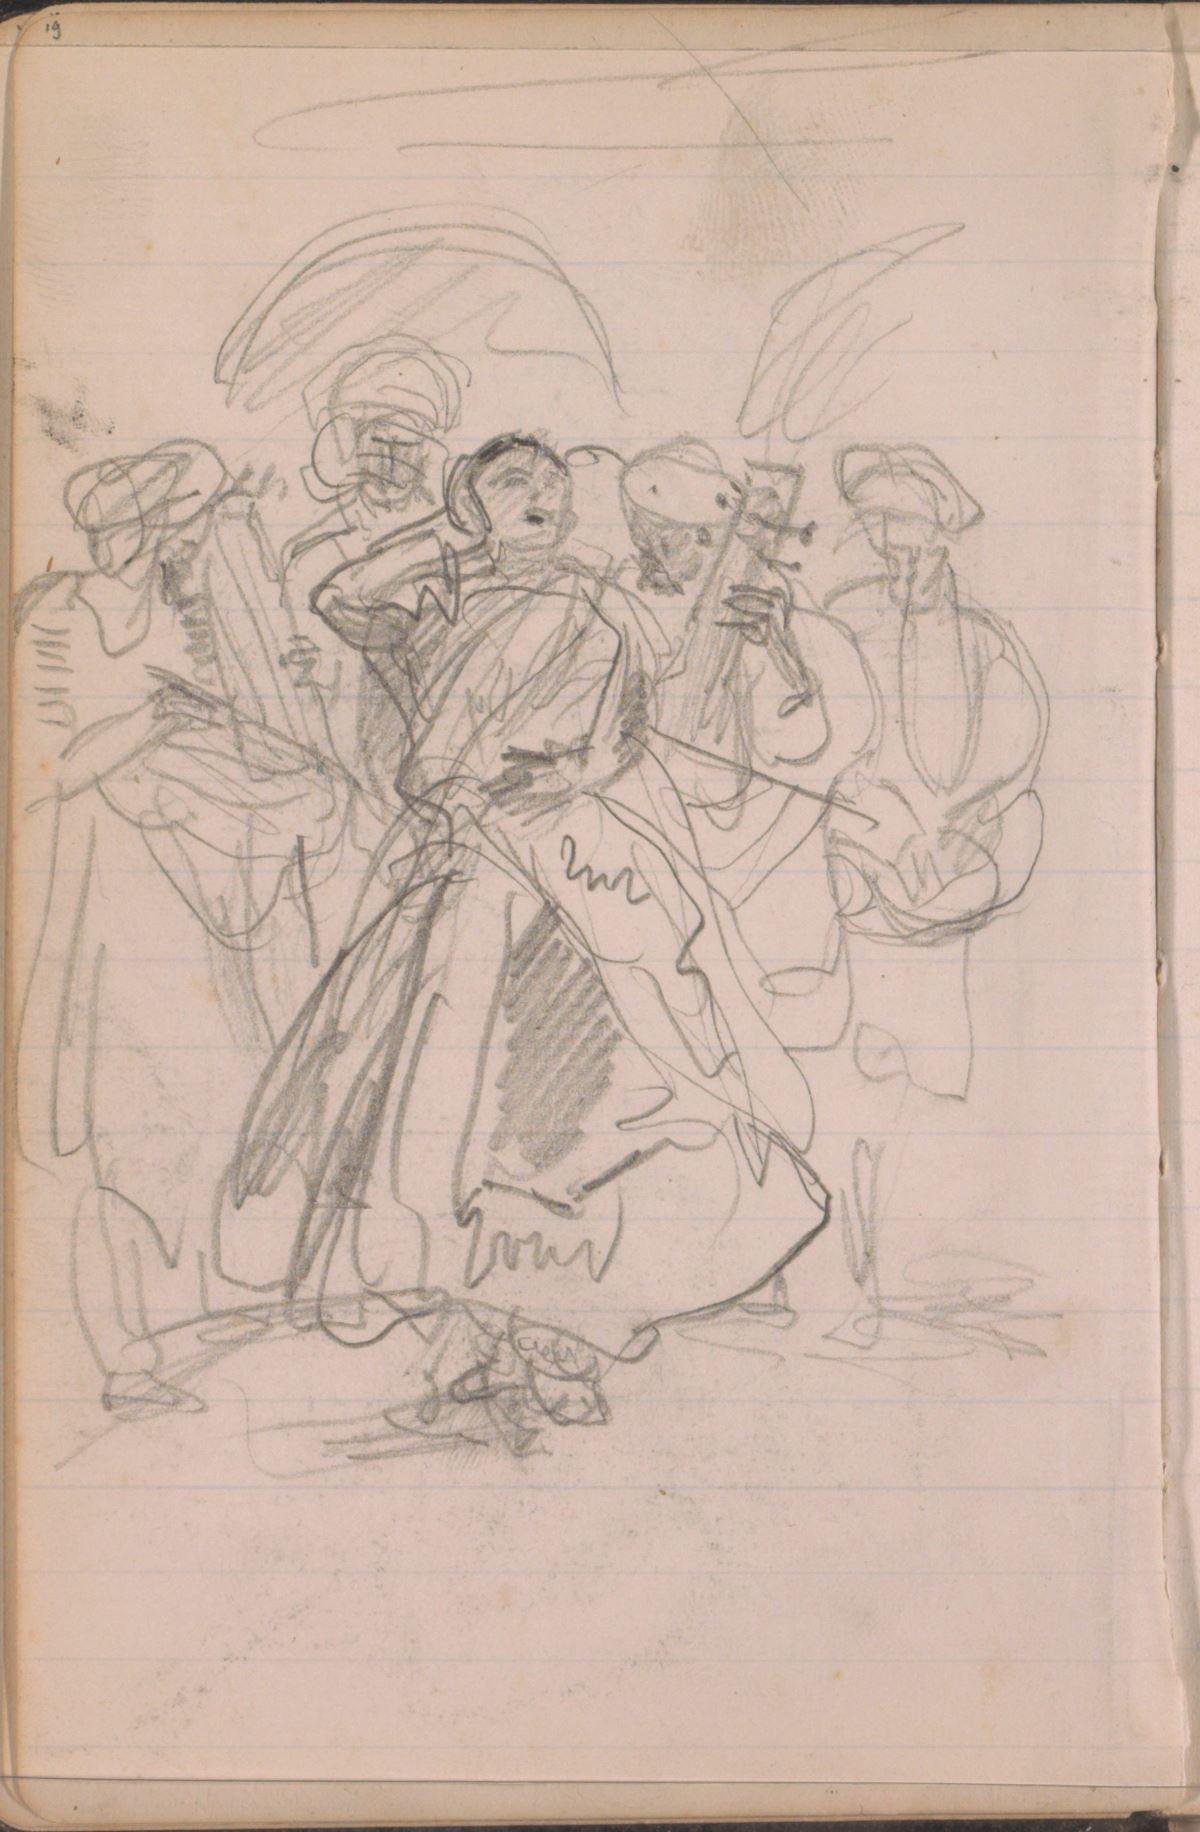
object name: sketchbook leaf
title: Muzikanten en een zangeres in een sari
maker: marius bauer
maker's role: draughtsman, print maker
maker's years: 1867-1932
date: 1897-1898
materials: pencil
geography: india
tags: musician, folk costume, regional costume, female singer, asiatic races and peoples: indians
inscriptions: kleurnotitie, handgeschreven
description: Pagina 19 uit een schetsboek met 84 bladen.